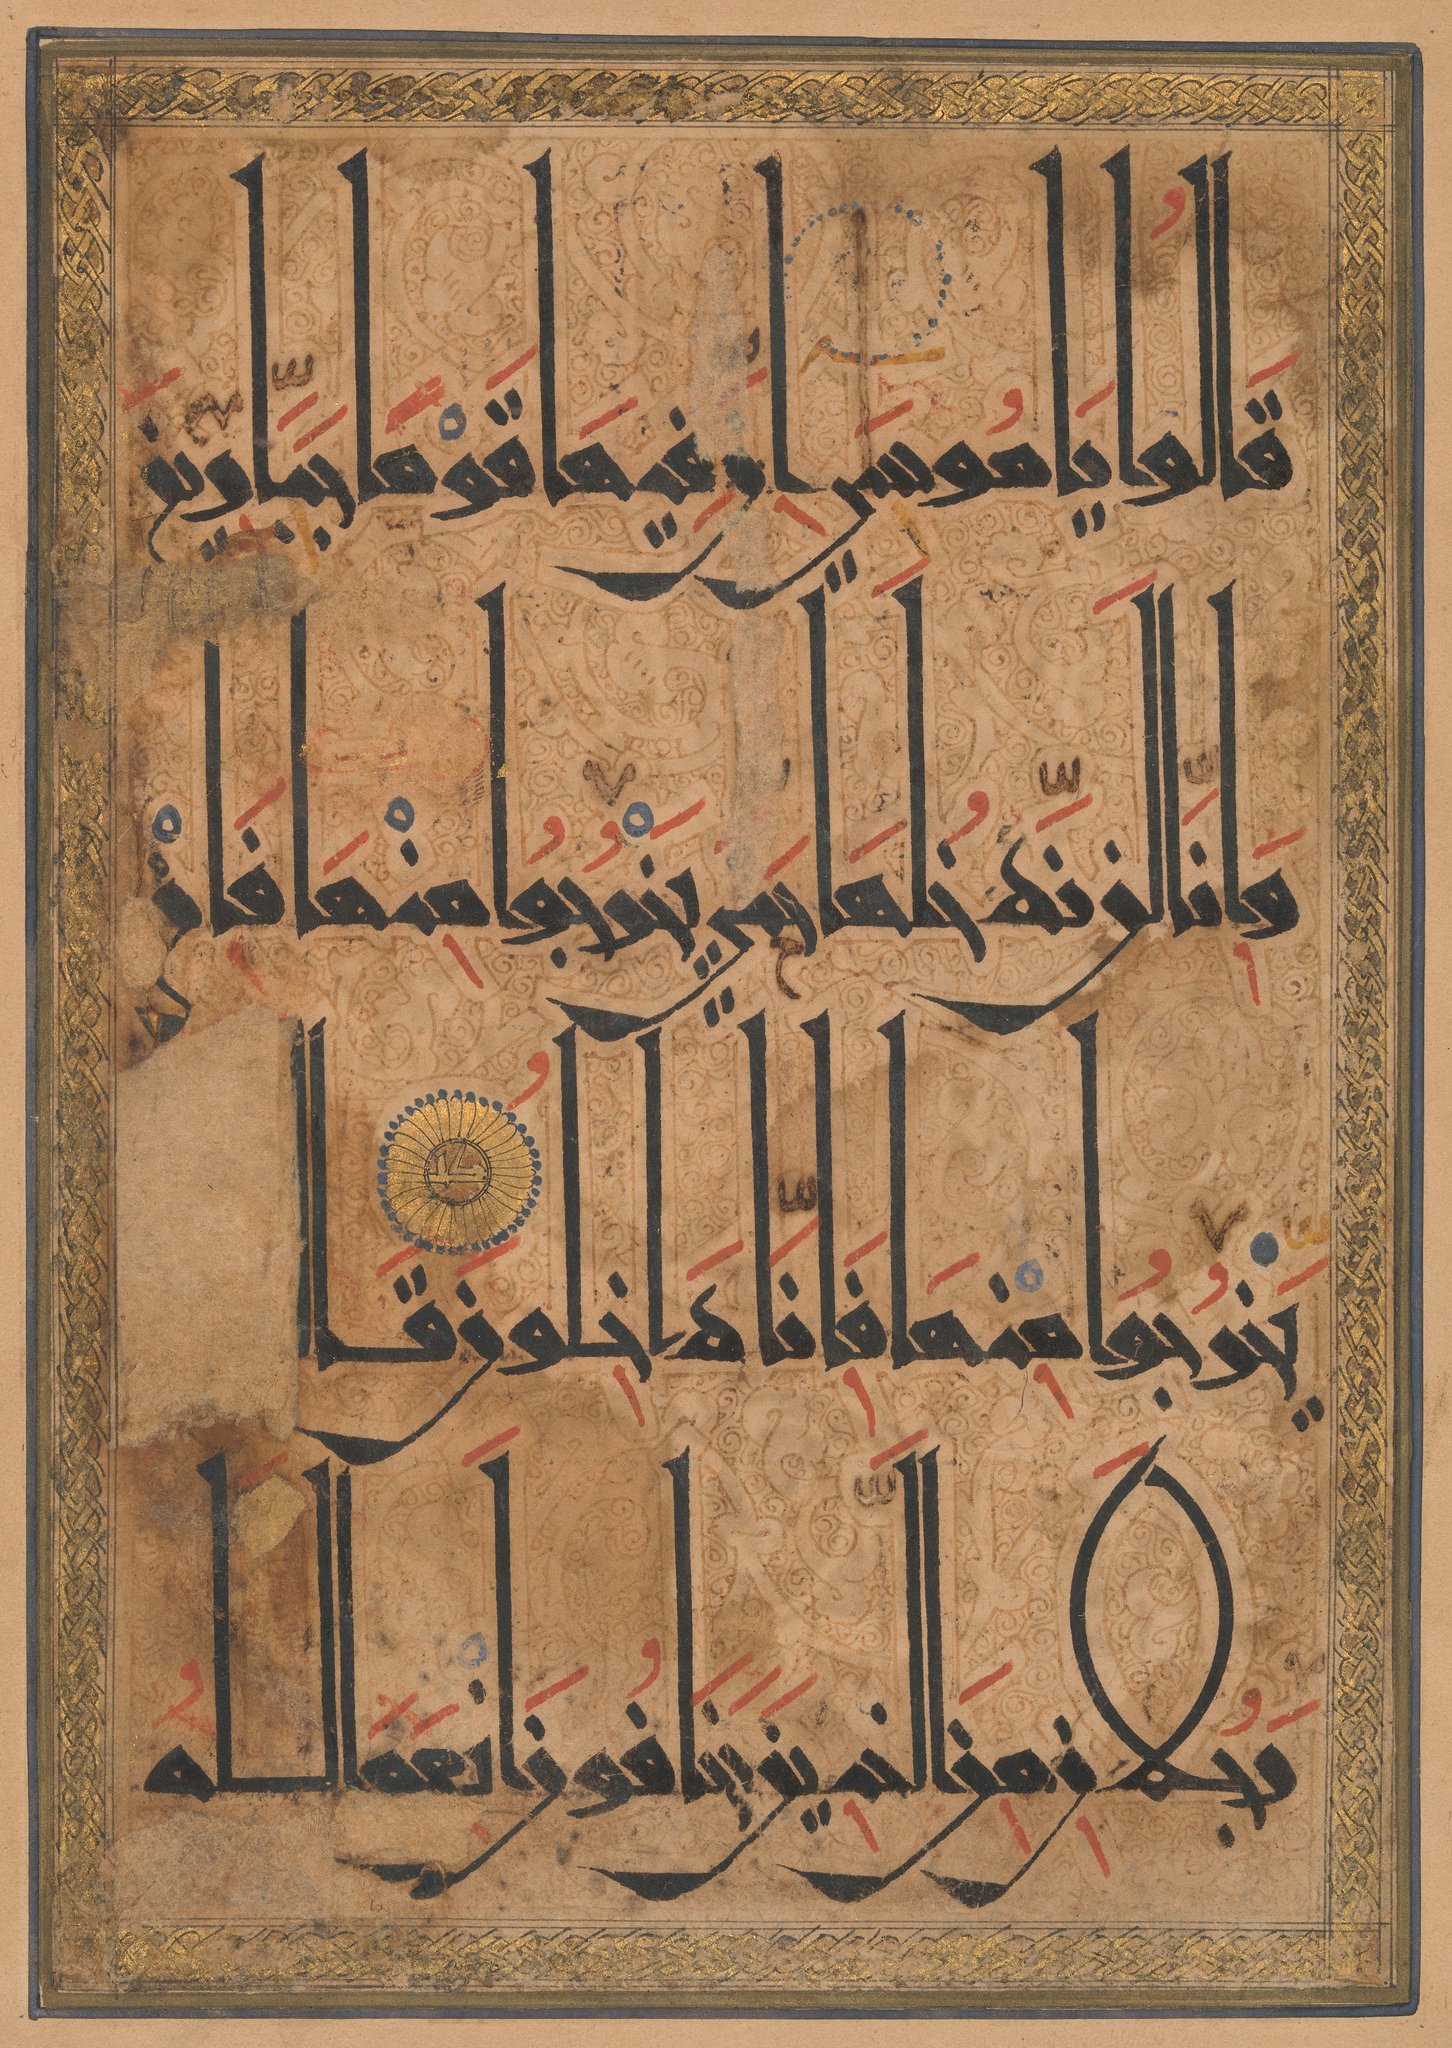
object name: folio from a non illustrated manuscript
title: Folio from a Qur'an Manuscript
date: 1180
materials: gold, ink, paper, watercolor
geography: iran or afghanistan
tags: qur'an